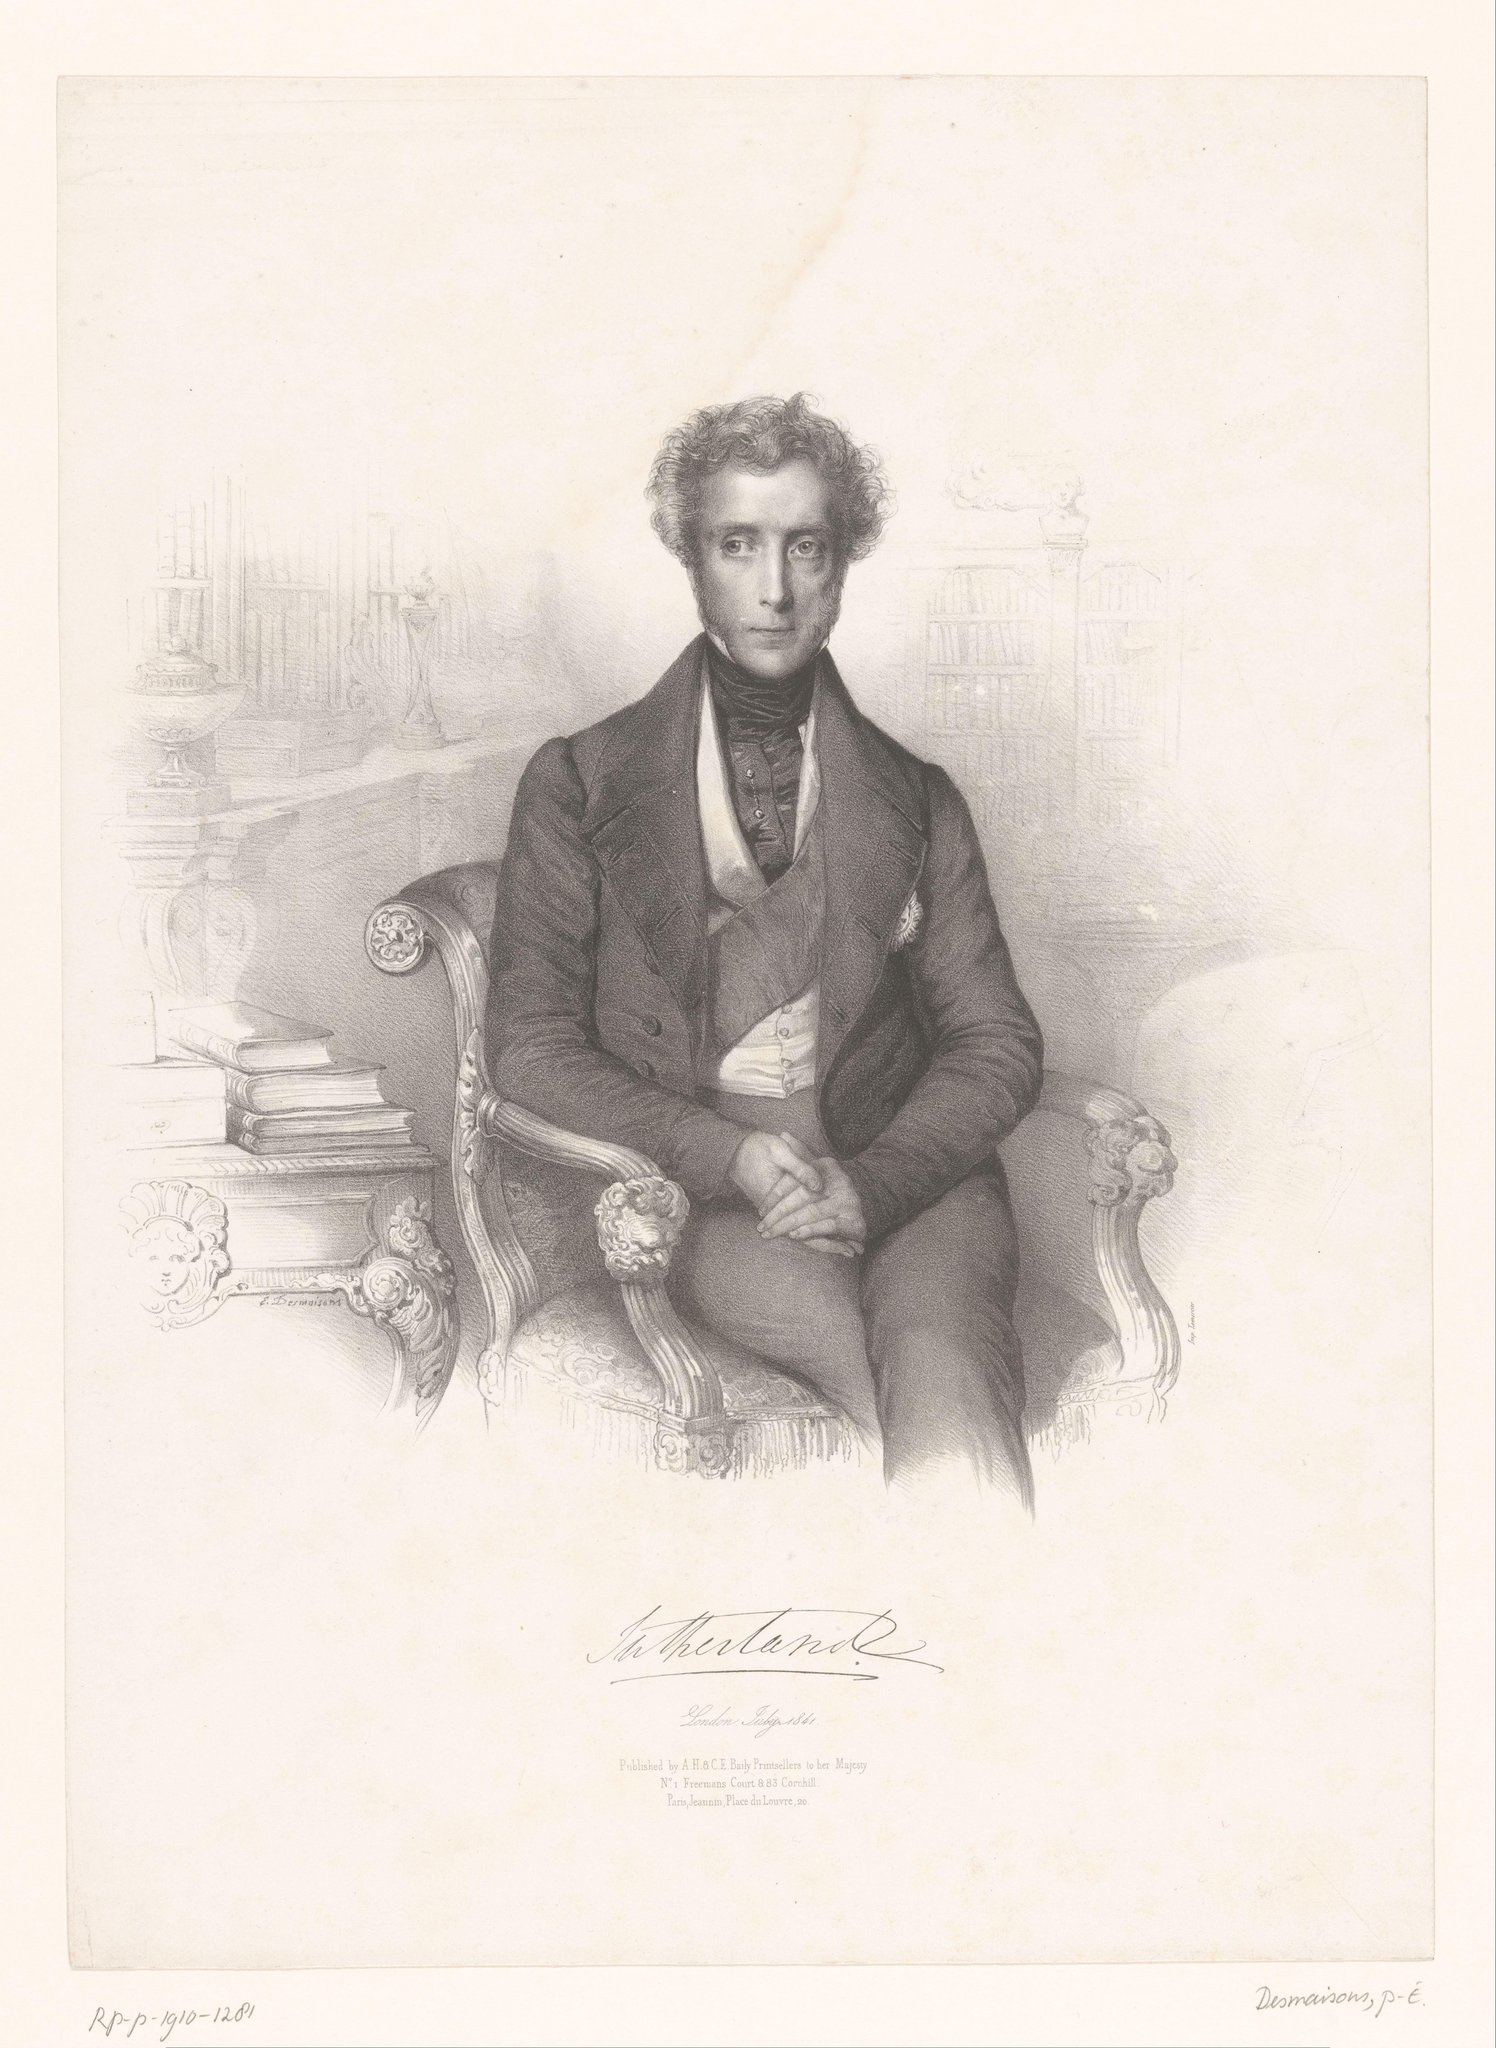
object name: print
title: Portret van George Sutherland-Leveson-Gower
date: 1841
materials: paper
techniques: lithograph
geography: paris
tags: politician, historical persons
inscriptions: collector's mark: Lugt 2228a